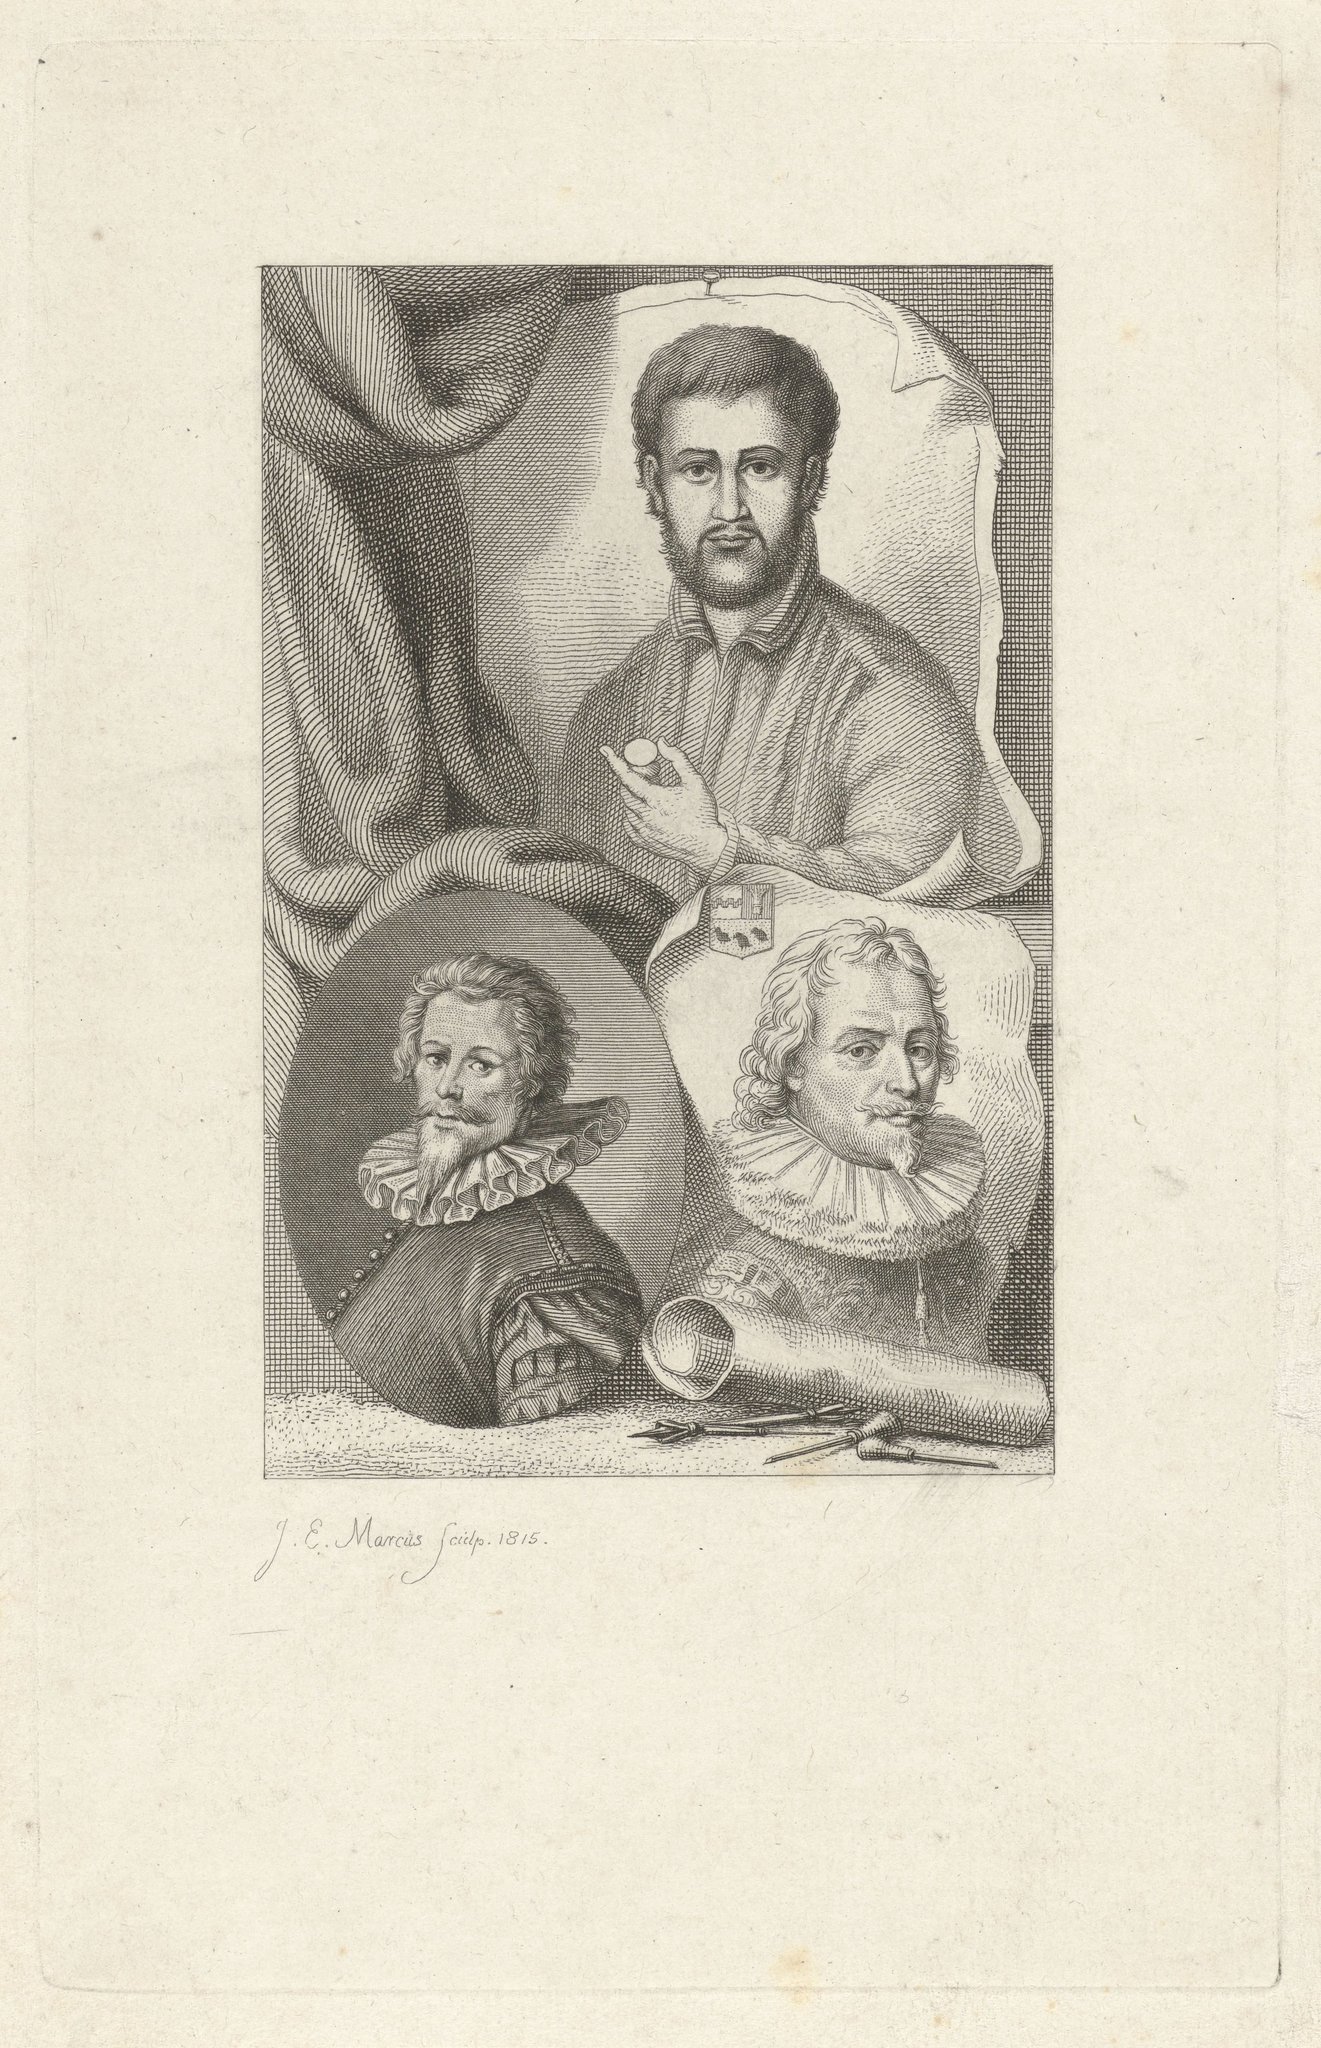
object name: print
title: Portretten van Janus Secundus, Claes Abrahamsz. van Delft en Willem Jacobsz. Delff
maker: jacob ernst marcus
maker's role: draughtsman, print maker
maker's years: 1774-1826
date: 1815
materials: paper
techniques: etching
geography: amsterdam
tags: delft, print maker, draughtsman, willem jacobsz delff, the hague, janus secundus, claes abrahamsz. van delft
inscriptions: collector's mark: Lugt 2228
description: Latere staat van de prent gebruikt in: Roeland van Eynden, Adriaan van der Willigen, Geschiedenis der vaderlansche schilderkunst, sedert de helft der XVIII eeuw. Haarlem, A. Loosjes, Pz [vanaf dl 3: Wed. A. Loosjes], 4 dln., 1816-40.